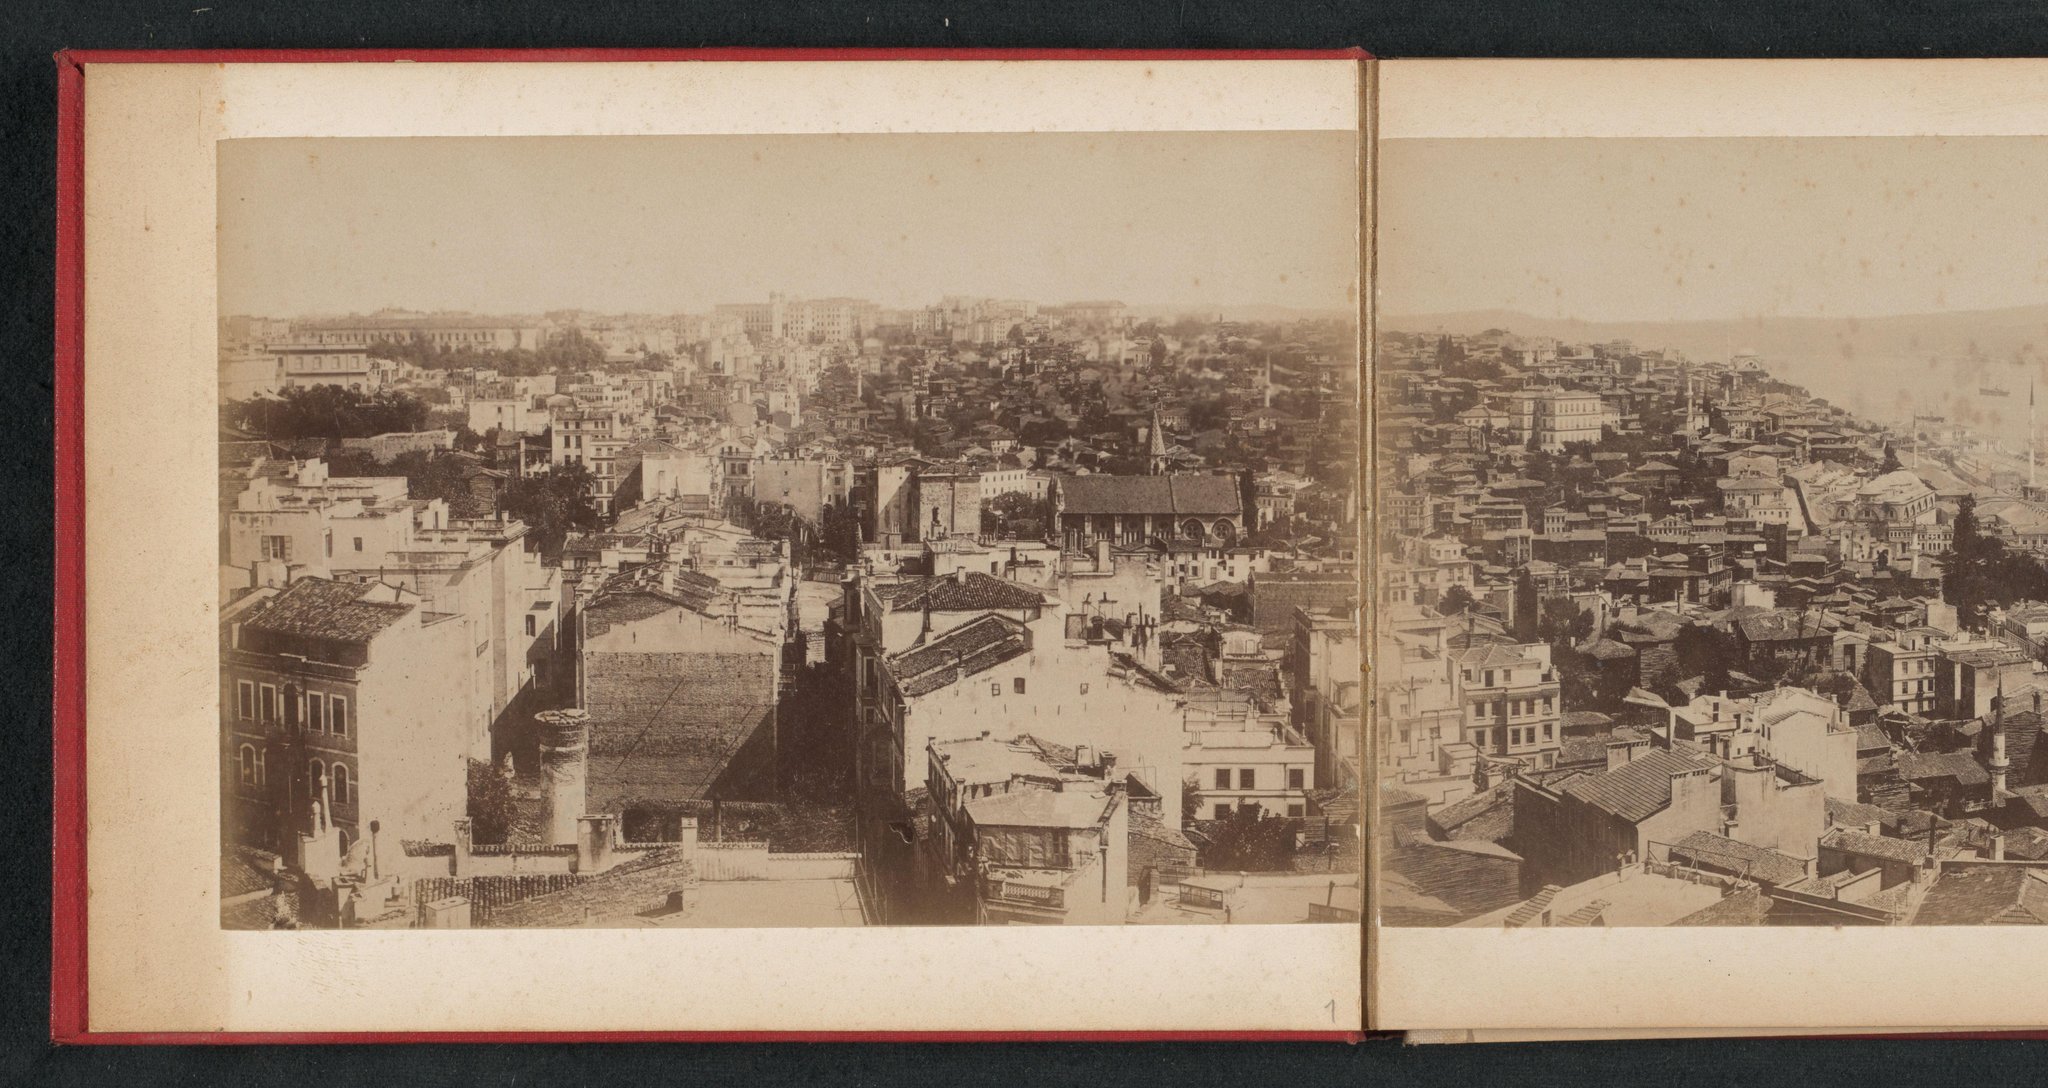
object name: photograph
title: Gezicht op een stadswijk aan de voet van de Galatatoren in Istanbul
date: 1890-1900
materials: cardboard, paper, photographic support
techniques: albumen print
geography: istanbul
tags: roof (of house or building), church (exterior), façade (of house or building), prospect of city, town panorama, silhouette of city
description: Onderdeel van Panorama van Istanbul en de Bosporus, foto 1 van 10.